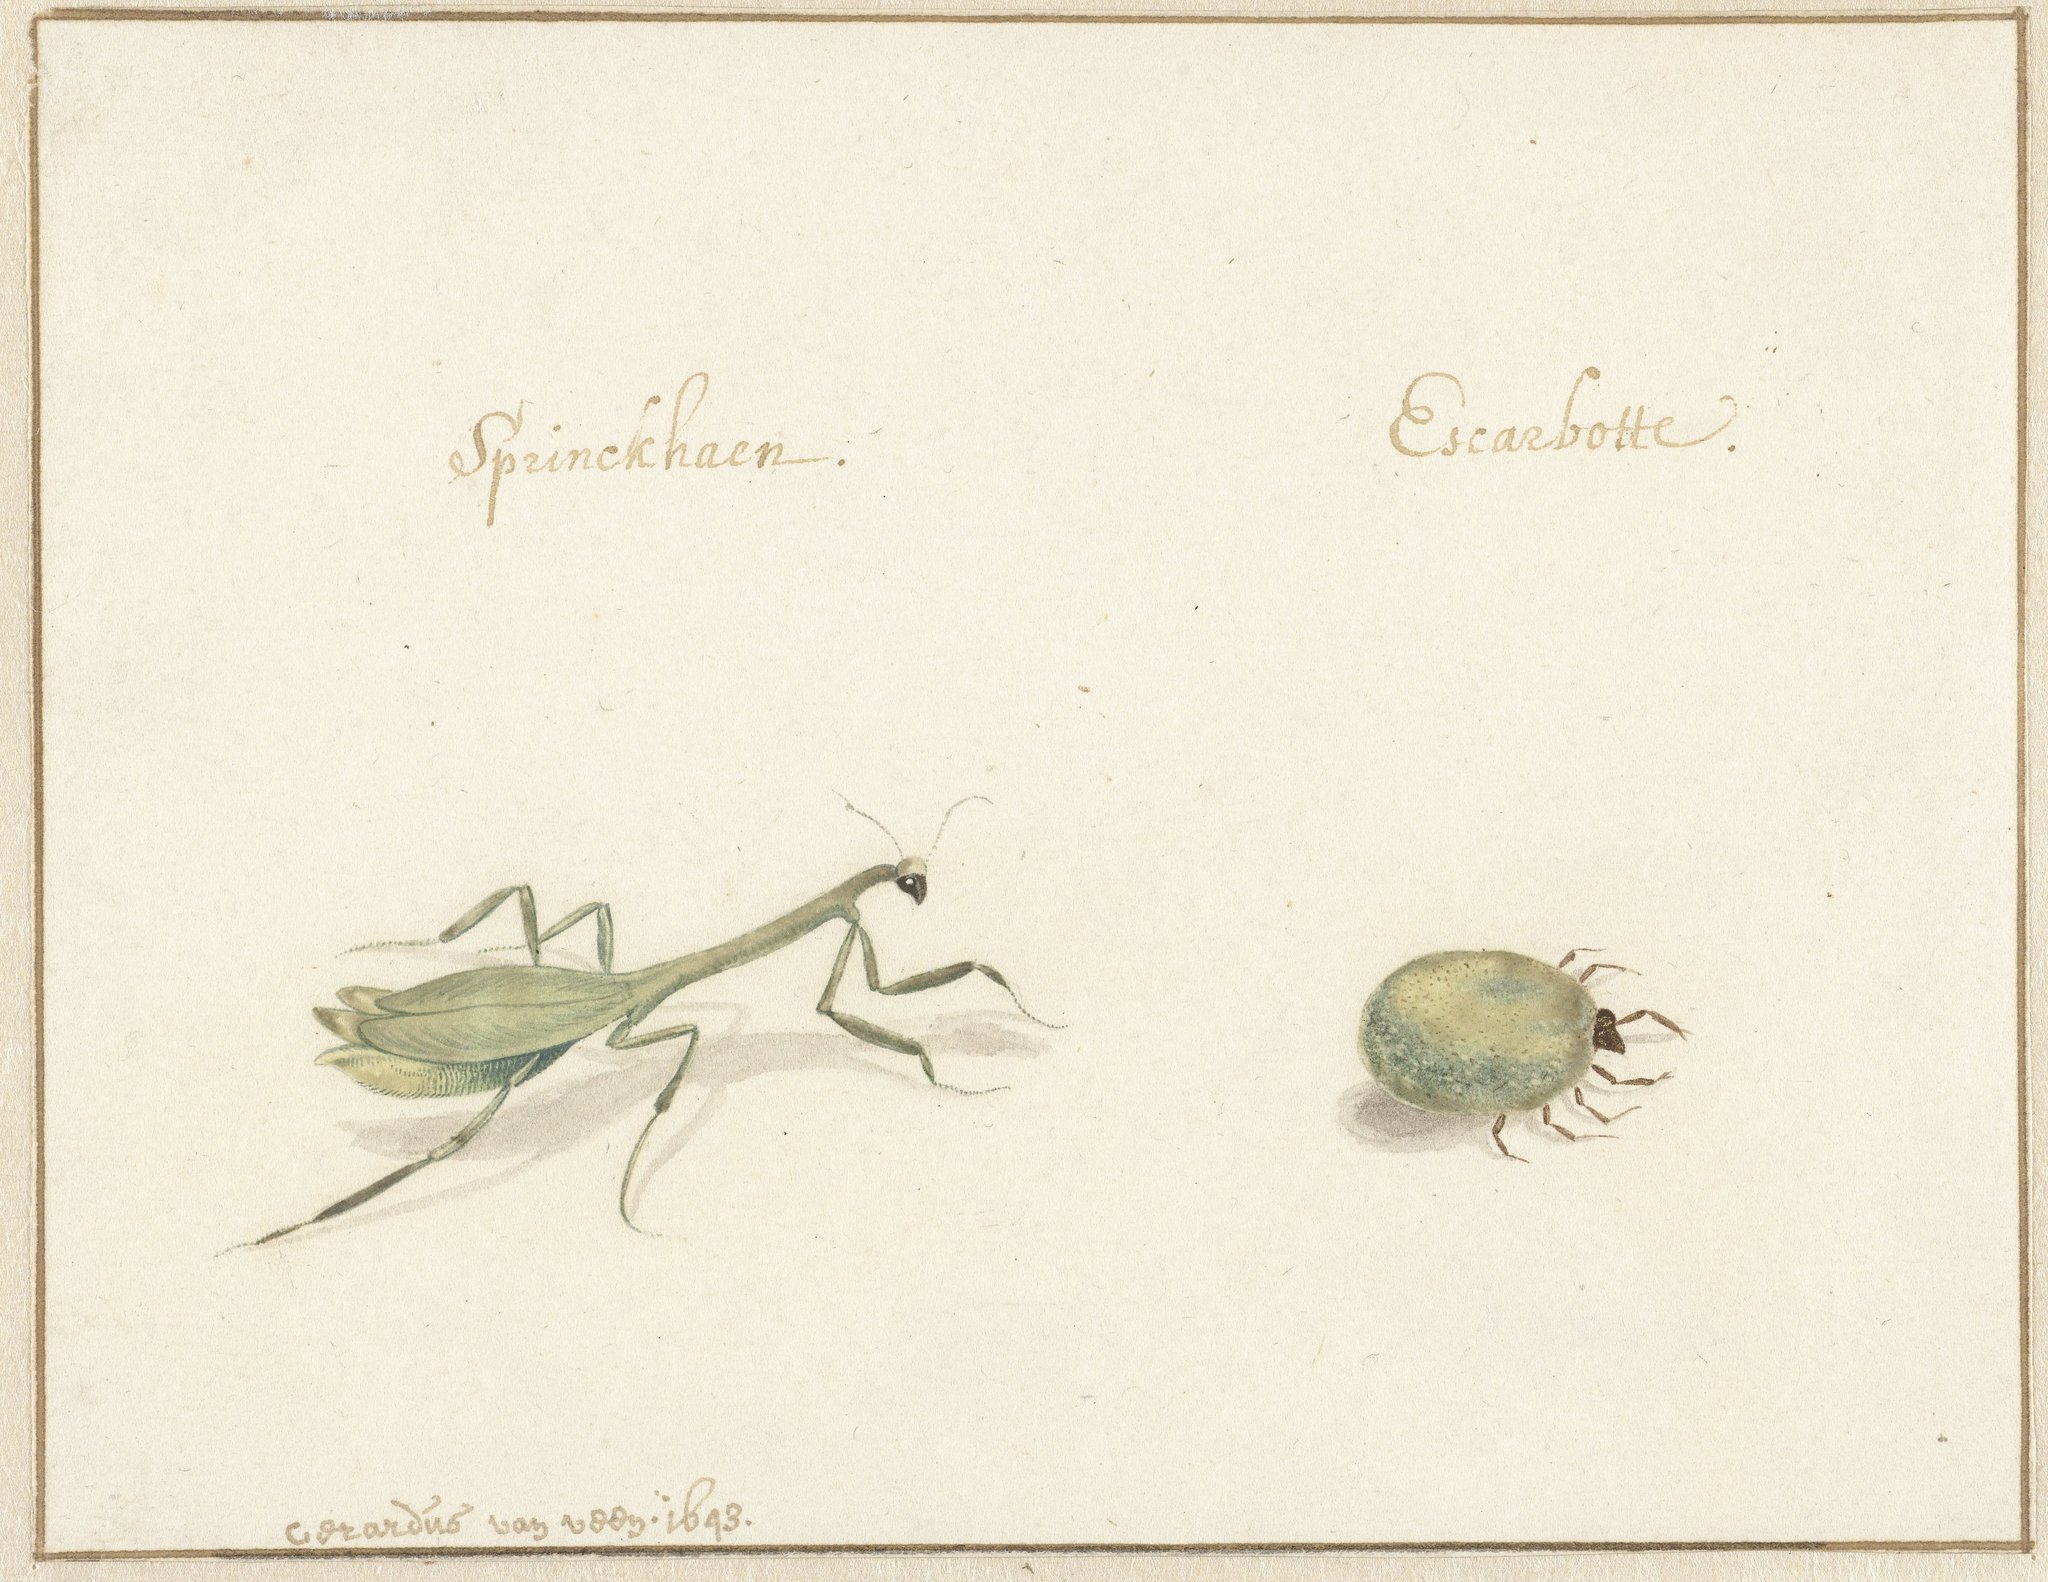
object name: watercolor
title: Twee insecten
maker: gerardus van veen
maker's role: draughtsman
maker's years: 1620-1683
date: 1643-1648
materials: paper, watercolor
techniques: brush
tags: insects: praying-mantis, insects: tick